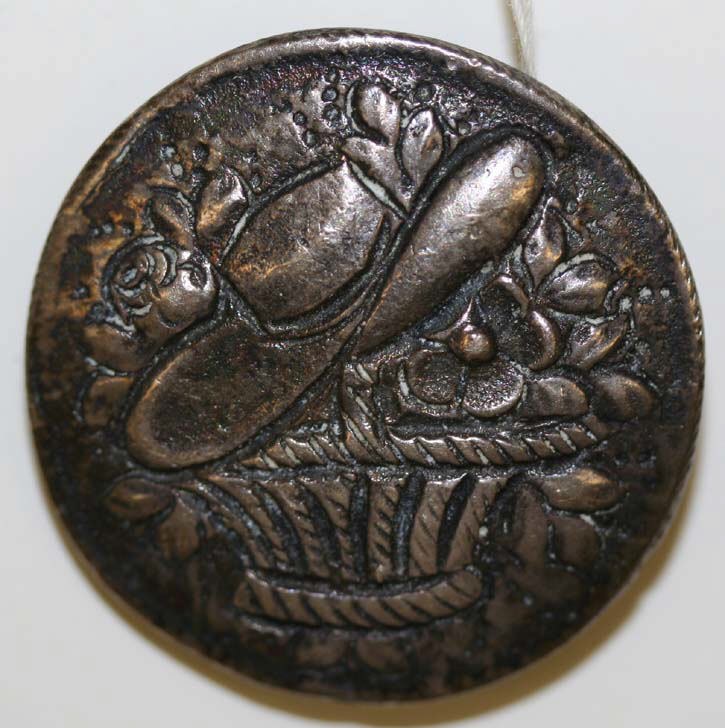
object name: button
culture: french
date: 1701-1800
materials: metal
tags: hats